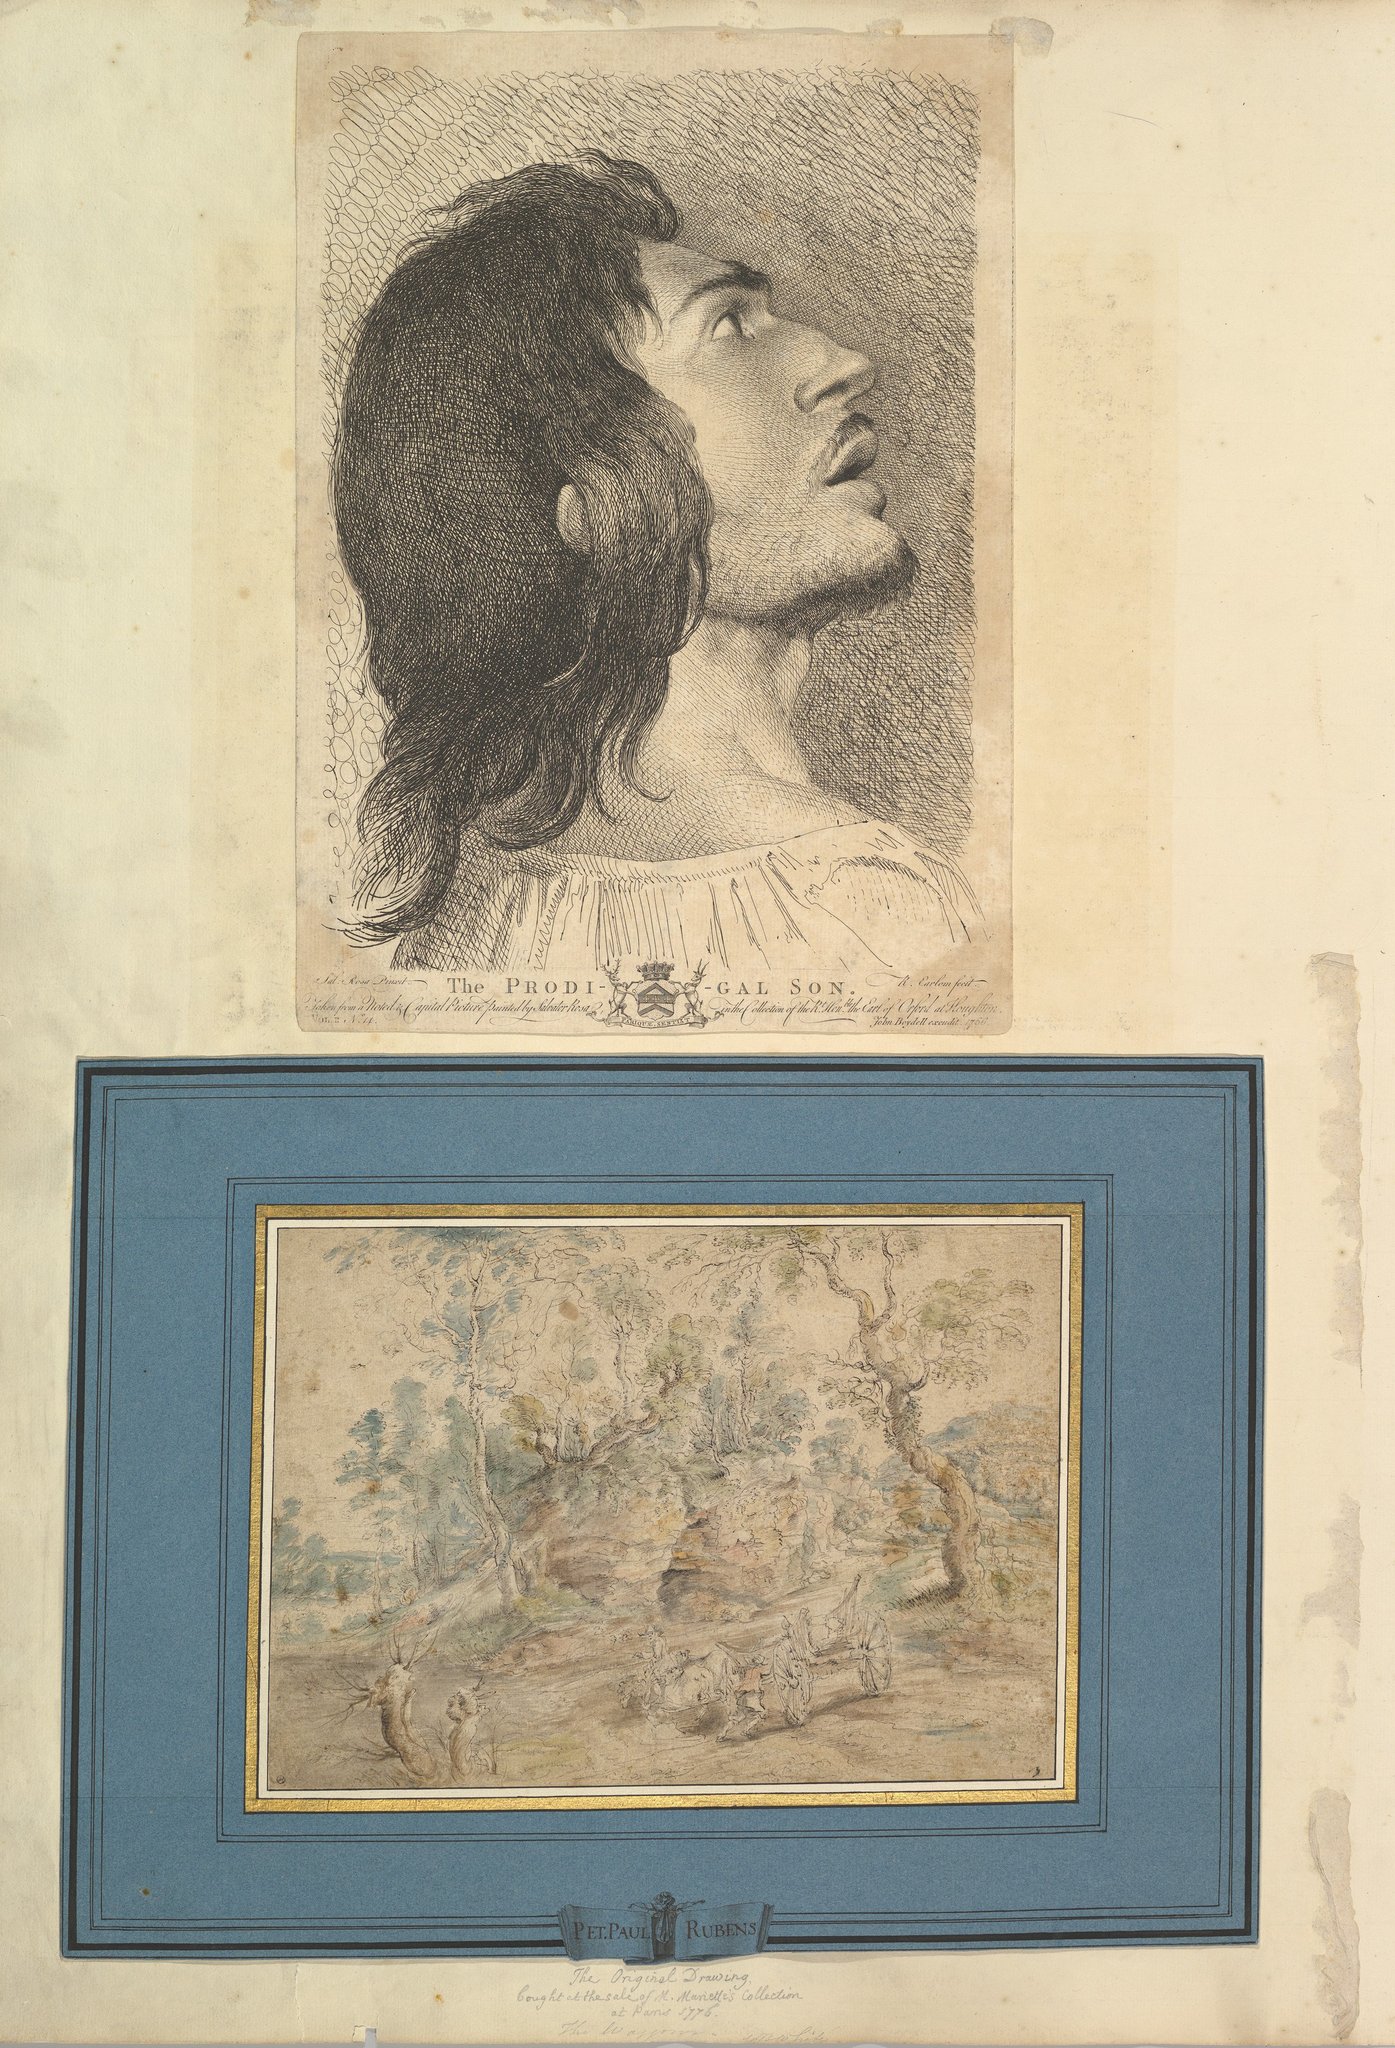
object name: drawing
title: Leaf from Aedes Walpolianae mounted with a print and a drawing (a): Head in Profile of Prodigal Son; (b): The Wagonner (after Peter Paul Rubens) in Jean-Paul Mariette mount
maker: richard earlom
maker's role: engraver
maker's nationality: british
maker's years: 1743-1822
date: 1620-1766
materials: graphite, ink, watercolor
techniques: engraving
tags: heads,men,profiles